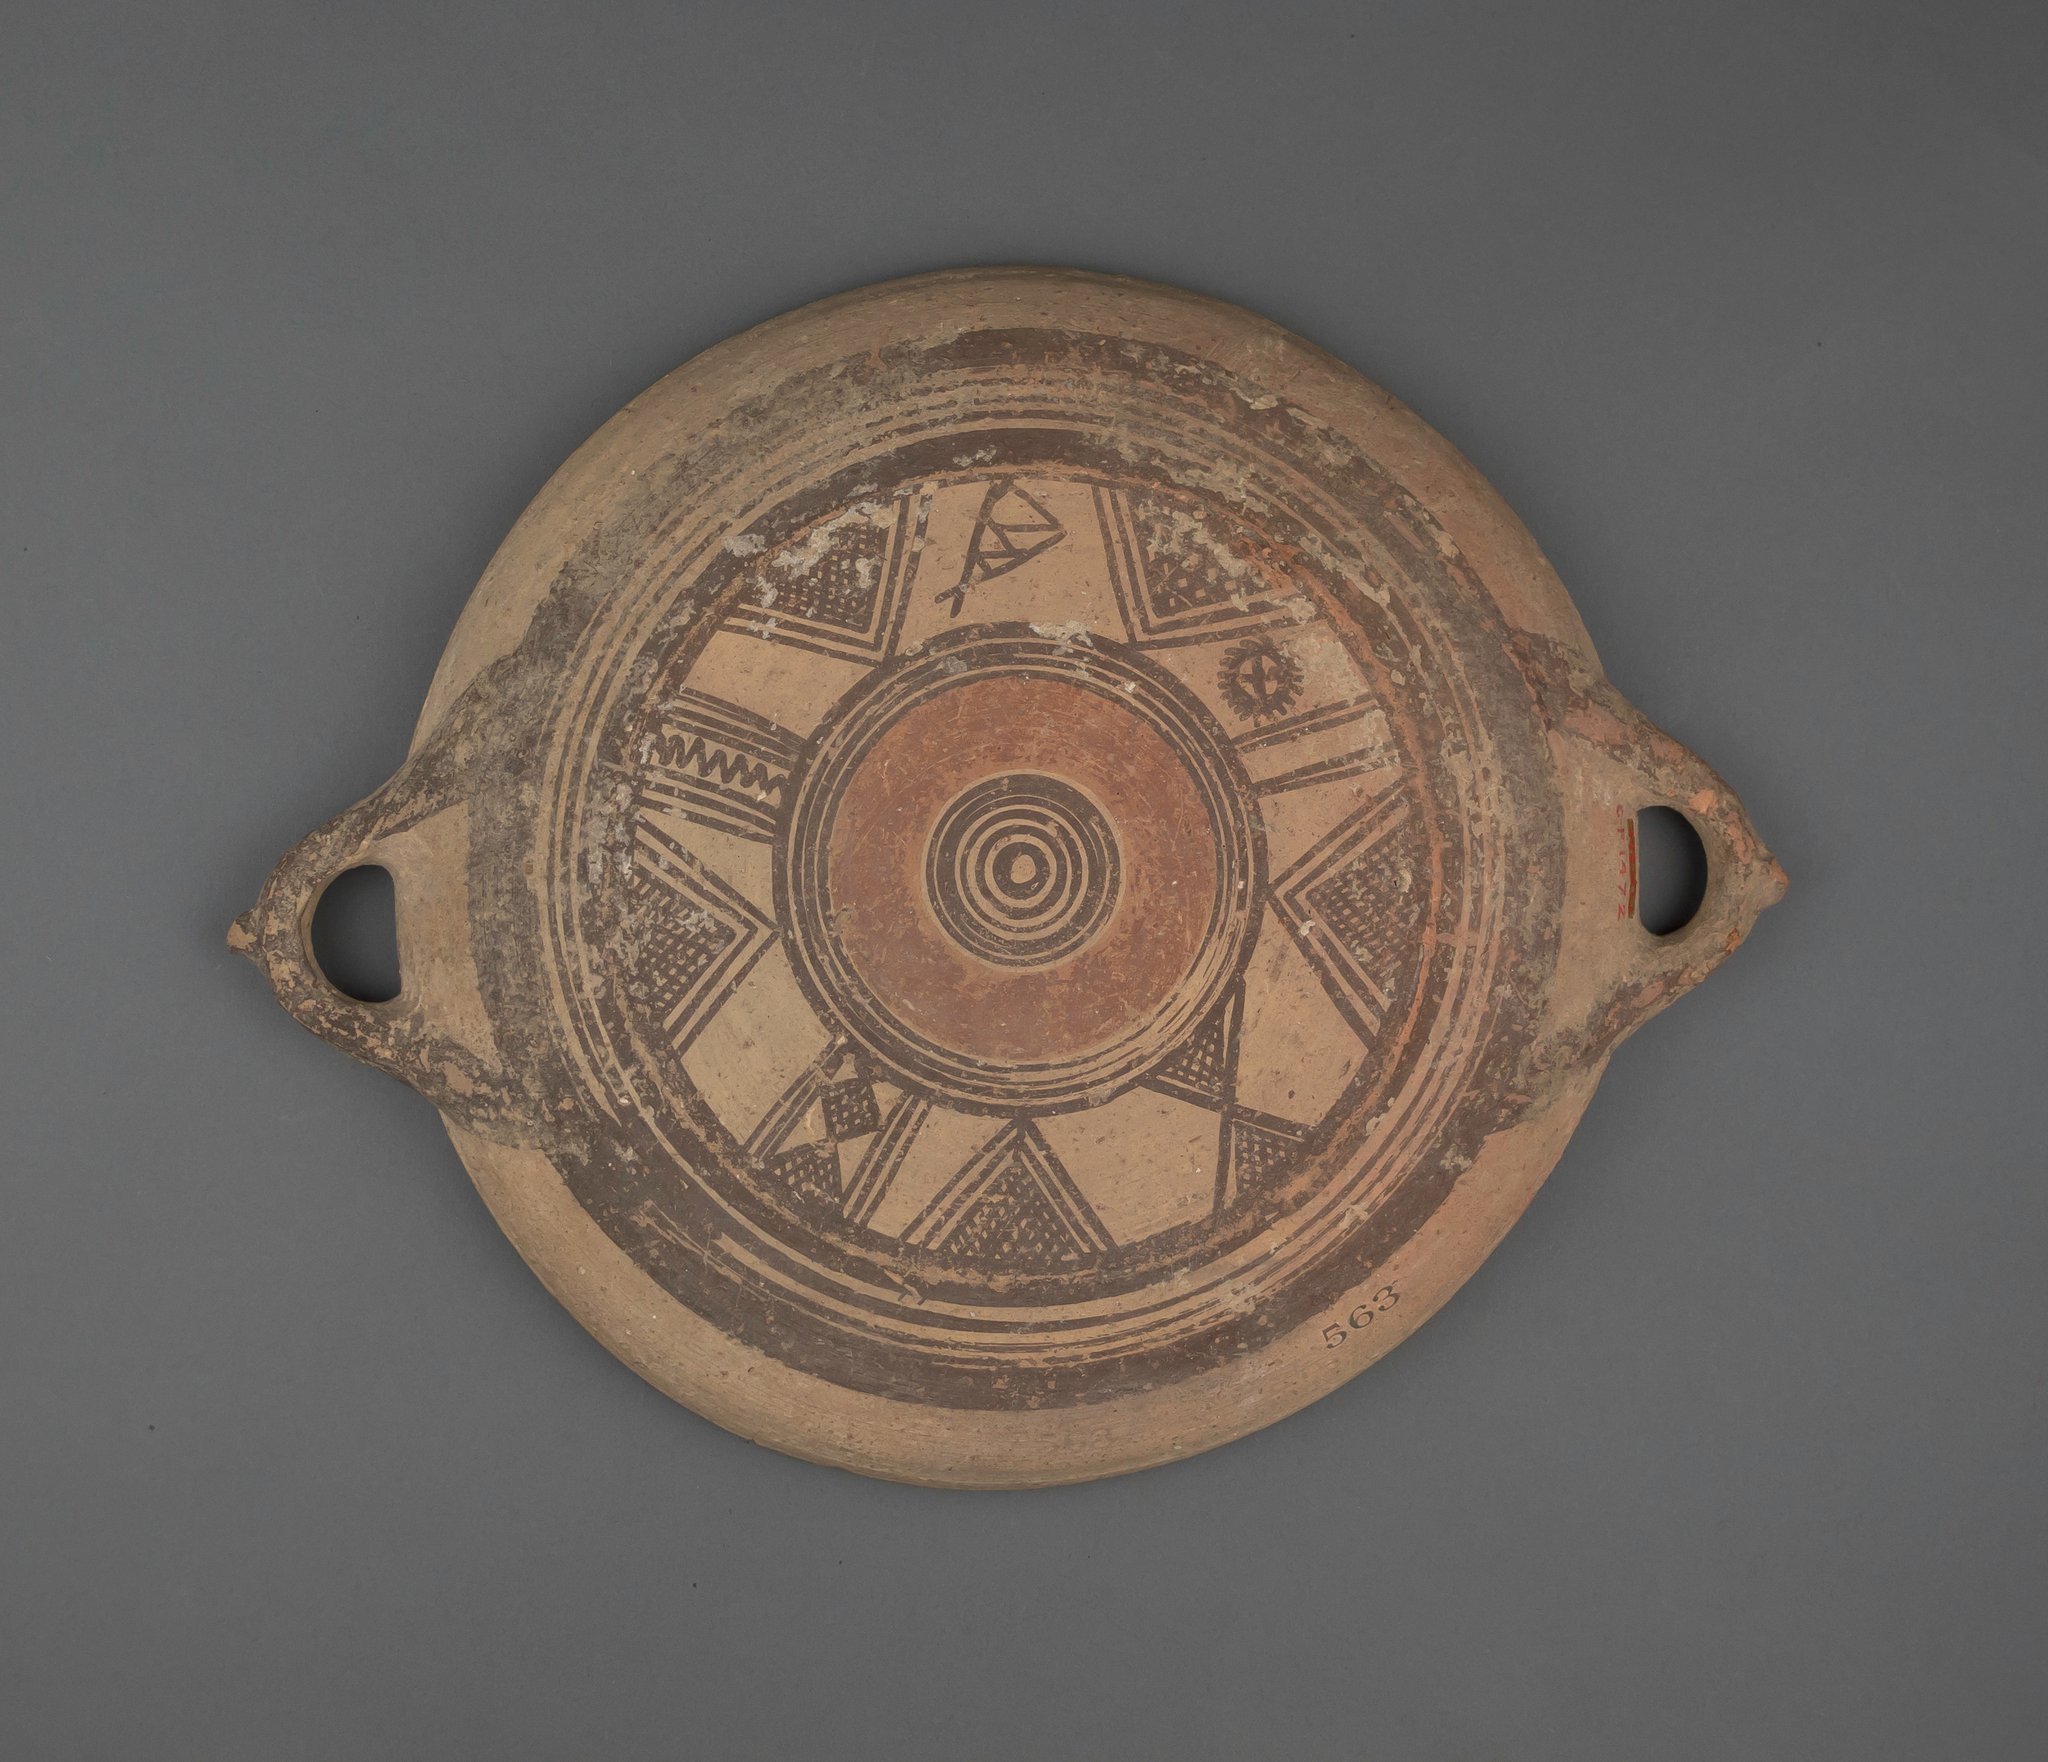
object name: plate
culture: cypriot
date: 950-850 BCE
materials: terracotta